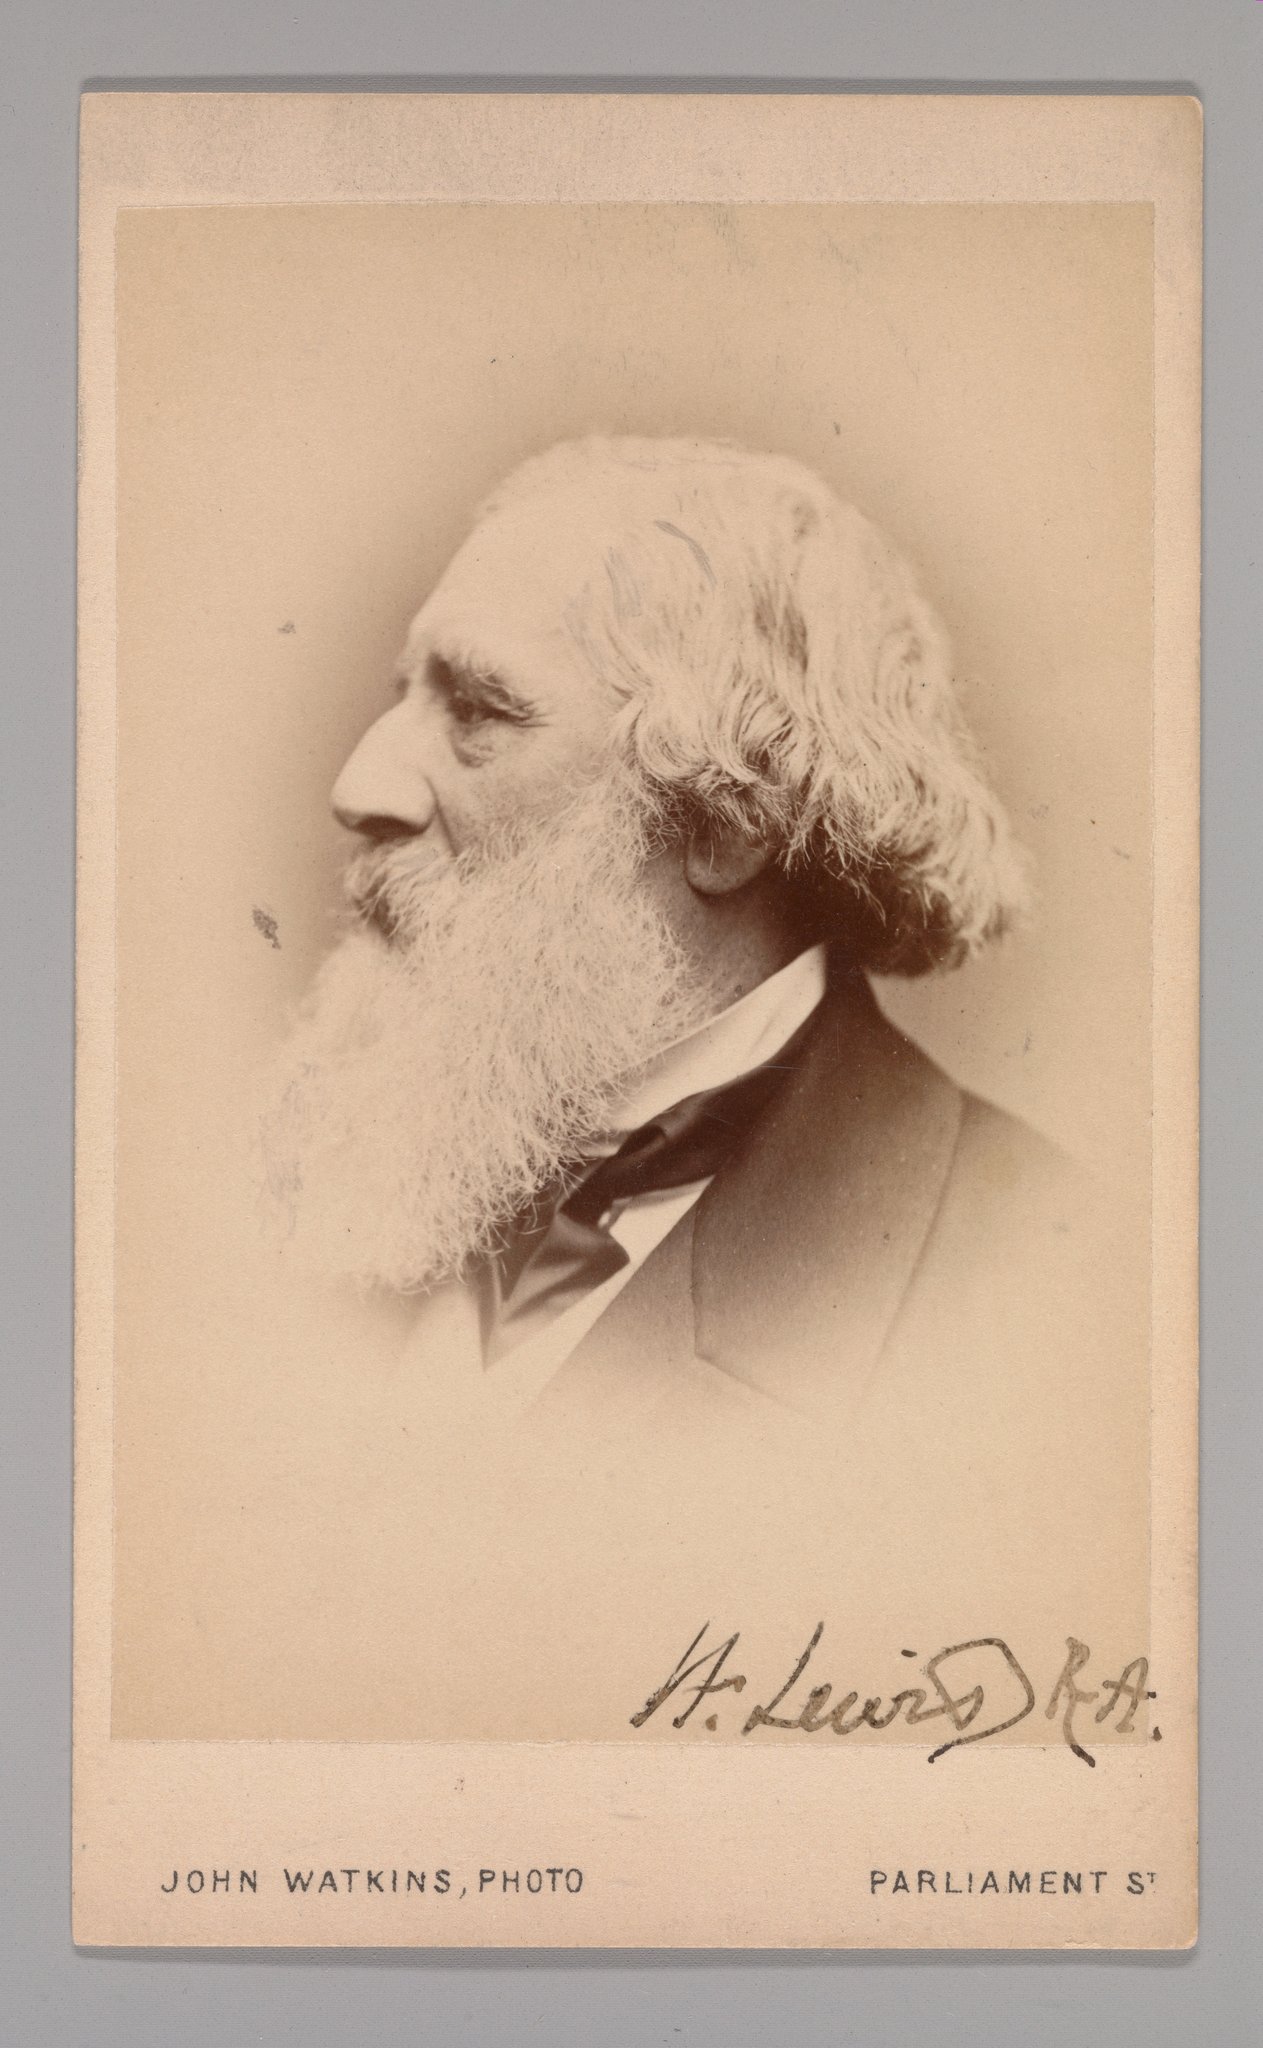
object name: carte de visite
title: [John Frederick Lewis]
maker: john and charles watkins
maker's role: photography studio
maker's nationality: british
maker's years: 1840-1875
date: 1860-1869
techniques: albumen silver print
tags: men,portraits,profiles